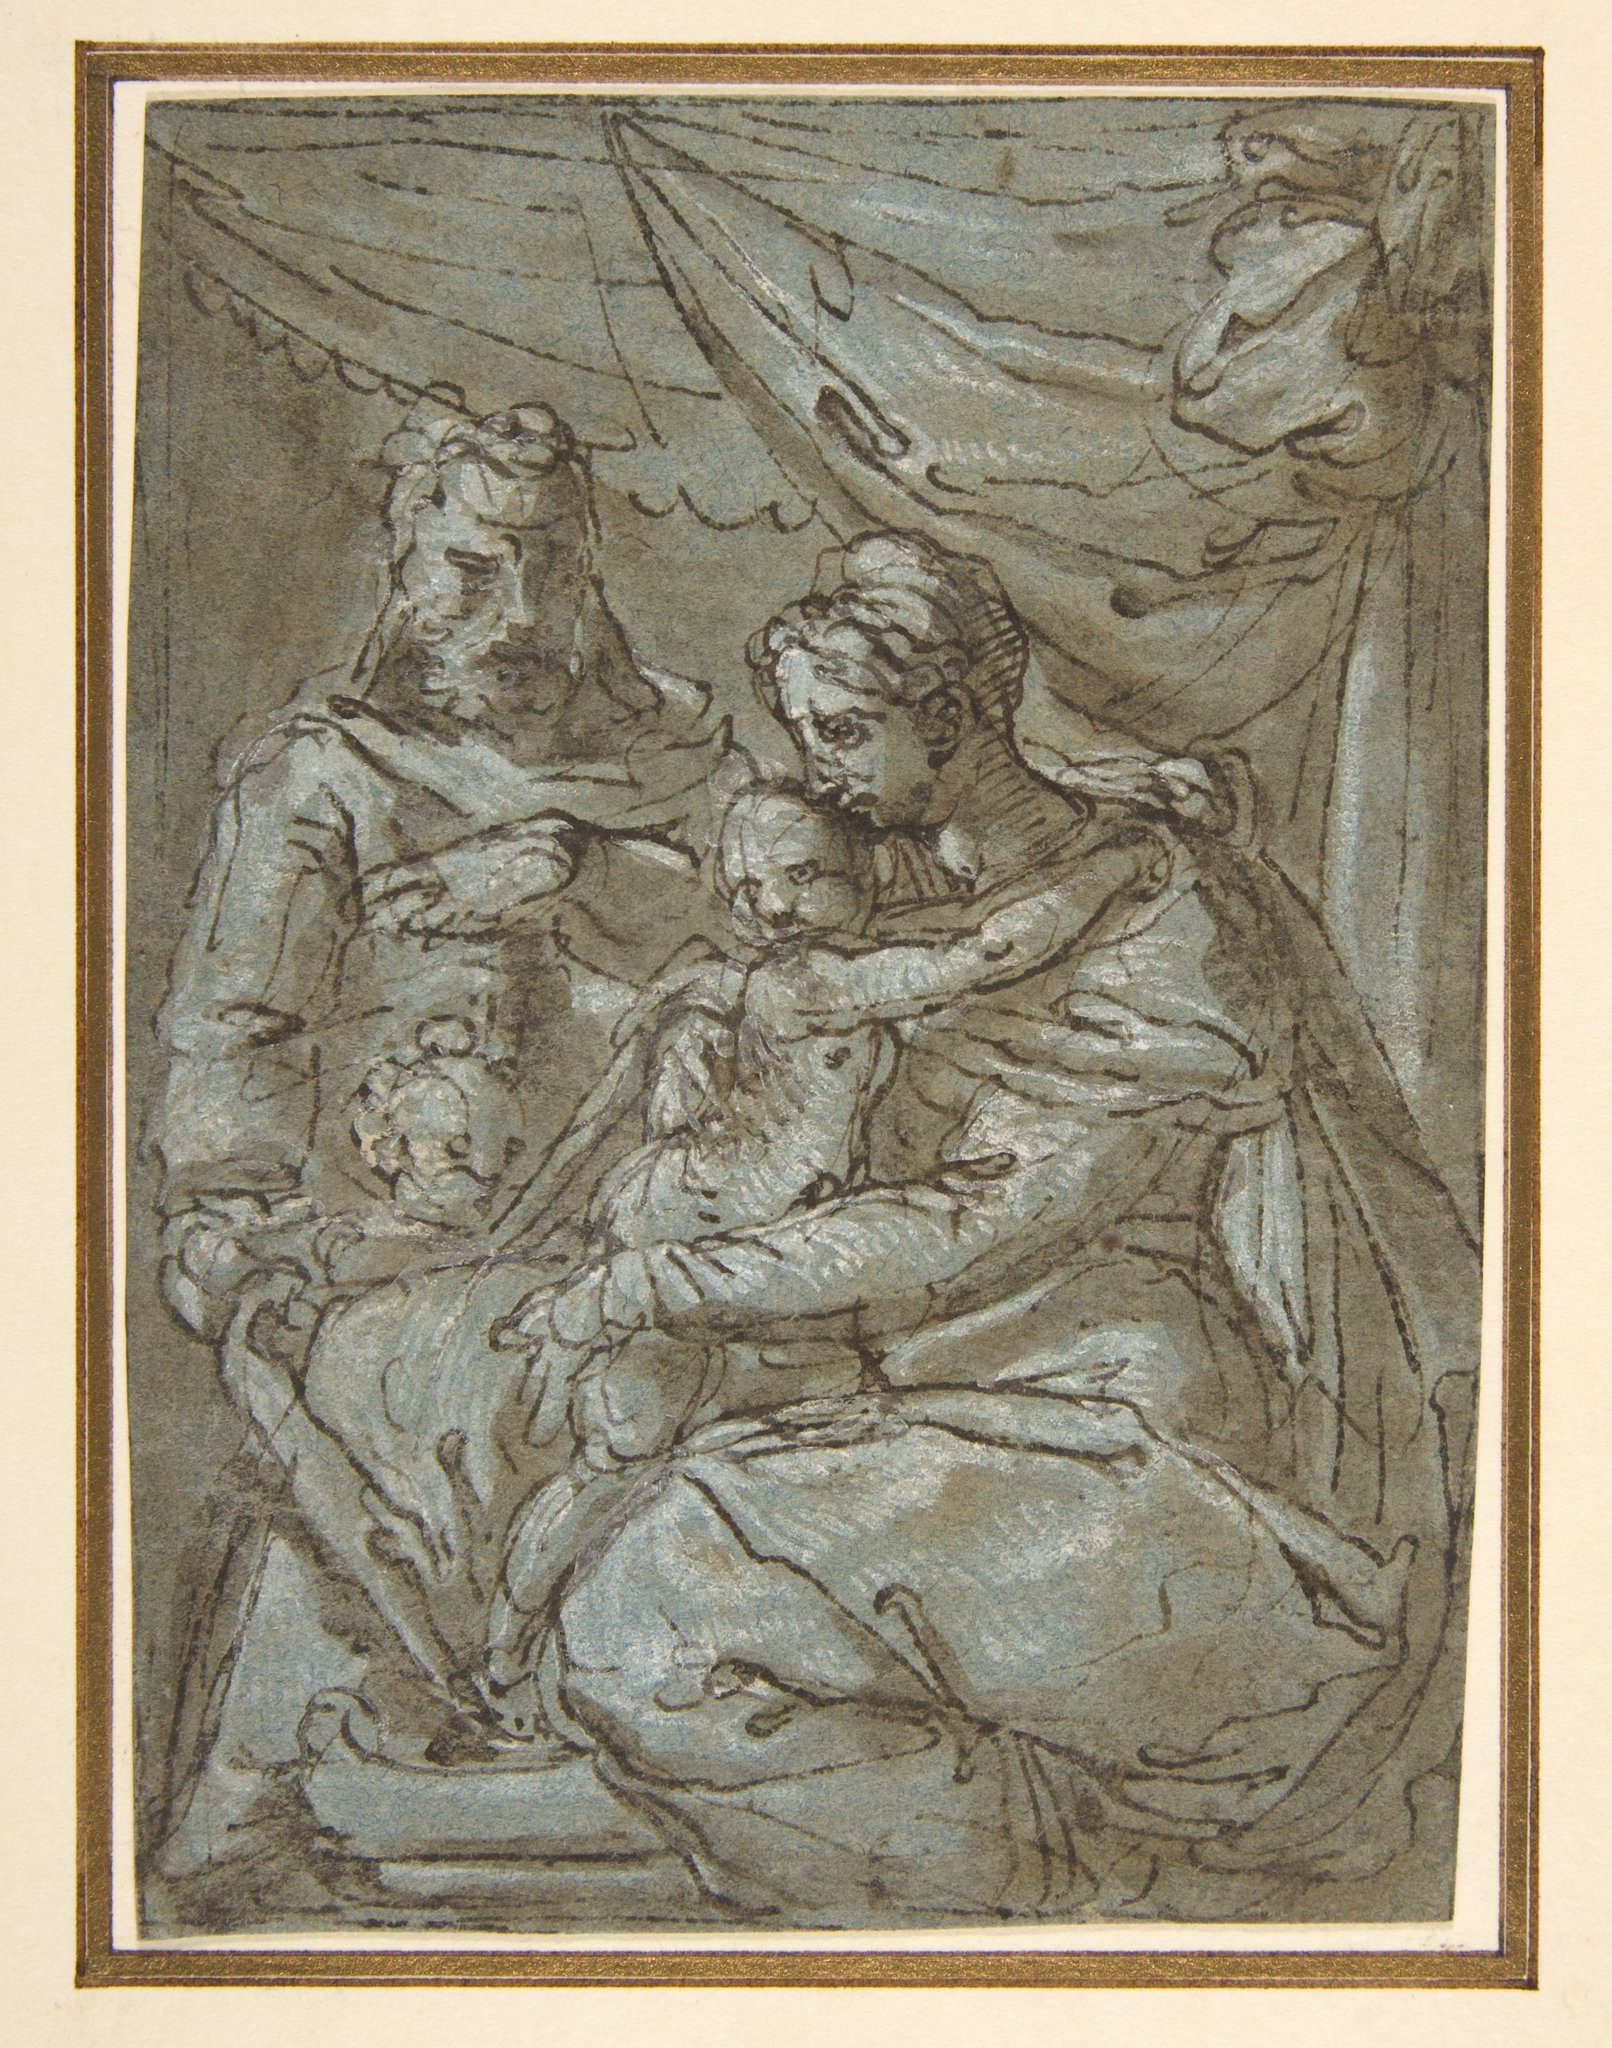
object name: drawing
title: The Holy Family with the Infant Baptist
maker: girolamo siciolante da sermoneta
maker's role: artist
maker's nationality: italian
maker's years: 1521-1575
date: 1521-1575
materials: ink, paper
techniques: brush, highlighting, pen, wash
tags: holy family,madonna and child,saint john the baptist